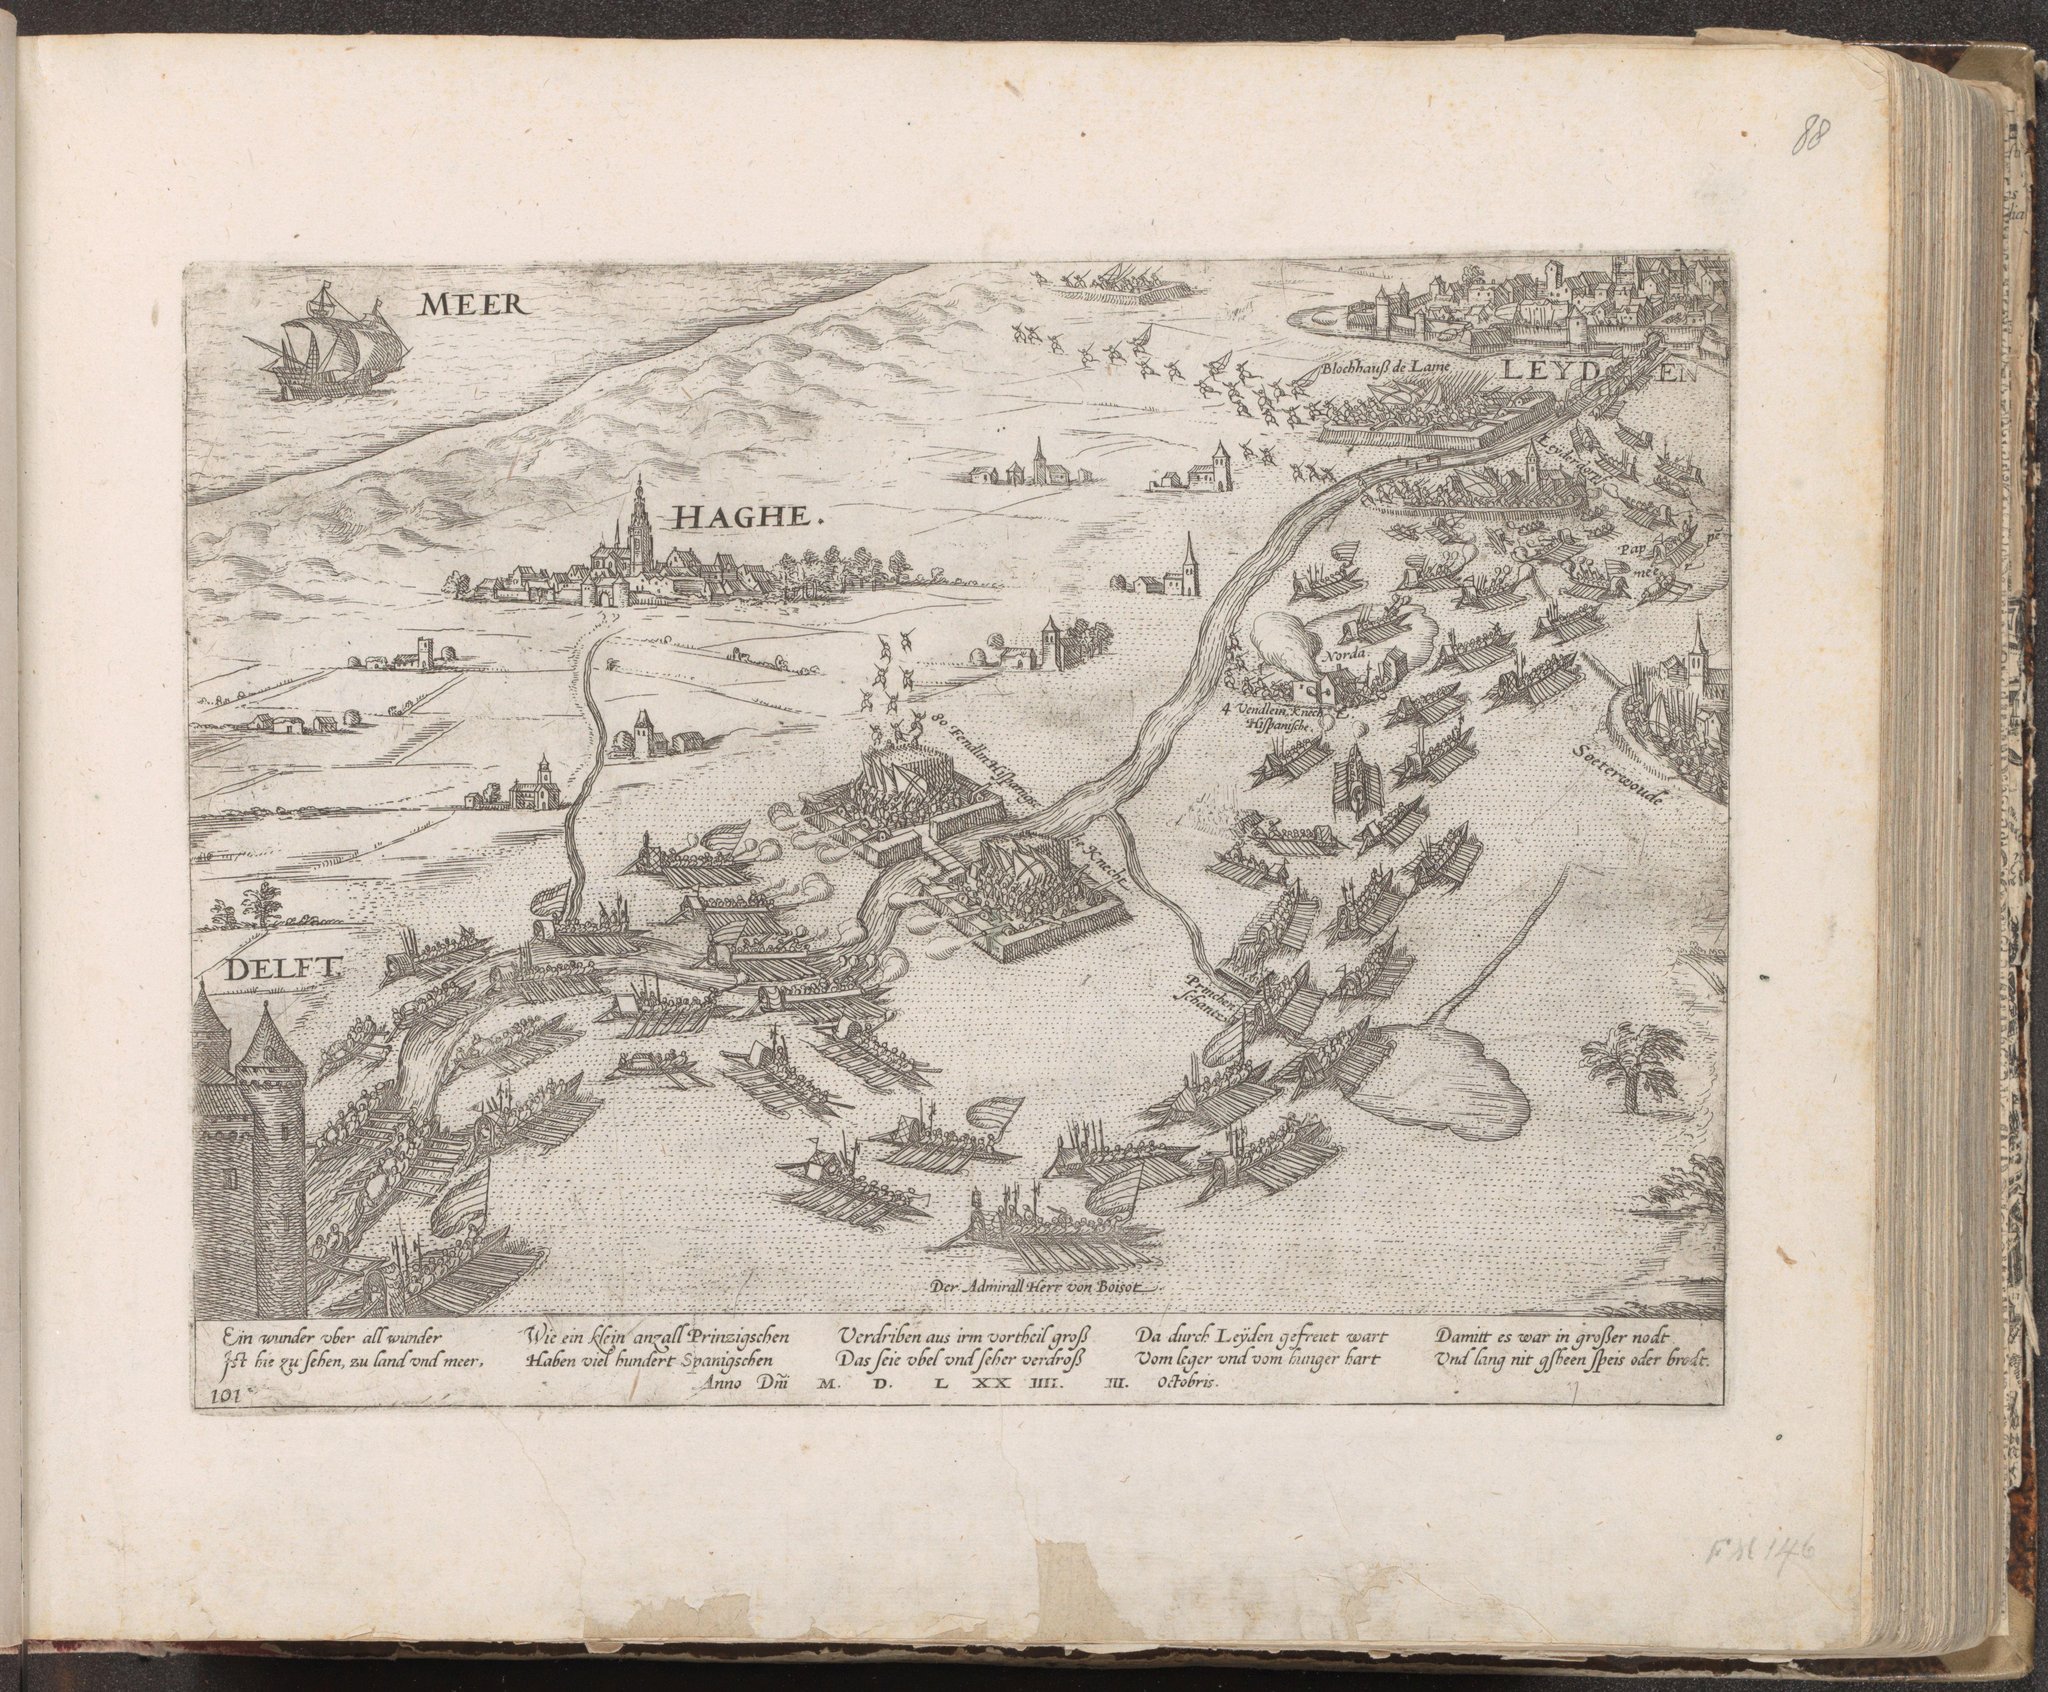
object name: album leaf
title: Serie 6: Nederlandse Gebeurtenissen, 1571-1576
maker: frans hogenberg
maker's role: print maker, publisher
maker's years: 1538-1590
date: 1574-1578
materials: paper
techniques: etching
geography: cologne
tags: brussels, raising the siege with outside assistance, relief, leiden, the hague, delft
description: Het ontzet van Leiden op 3 oktober 1574. Troepen van de prins varen over de ondergelopen polders van Delft langs Den Haag naar Leiden, onder bevel van admiraal Louis de Boisot. Spaanse belegeraars vluchten vanuit hun stellingen. Met onderschrift van 10 regels in het Duits. Linksonder genummerd: 101. De prent maakt deel uit van een album.